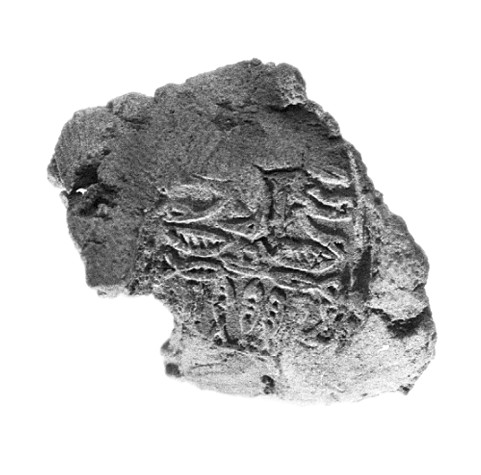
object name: sealing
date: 1981-1640 BCE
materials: mud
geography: egypt